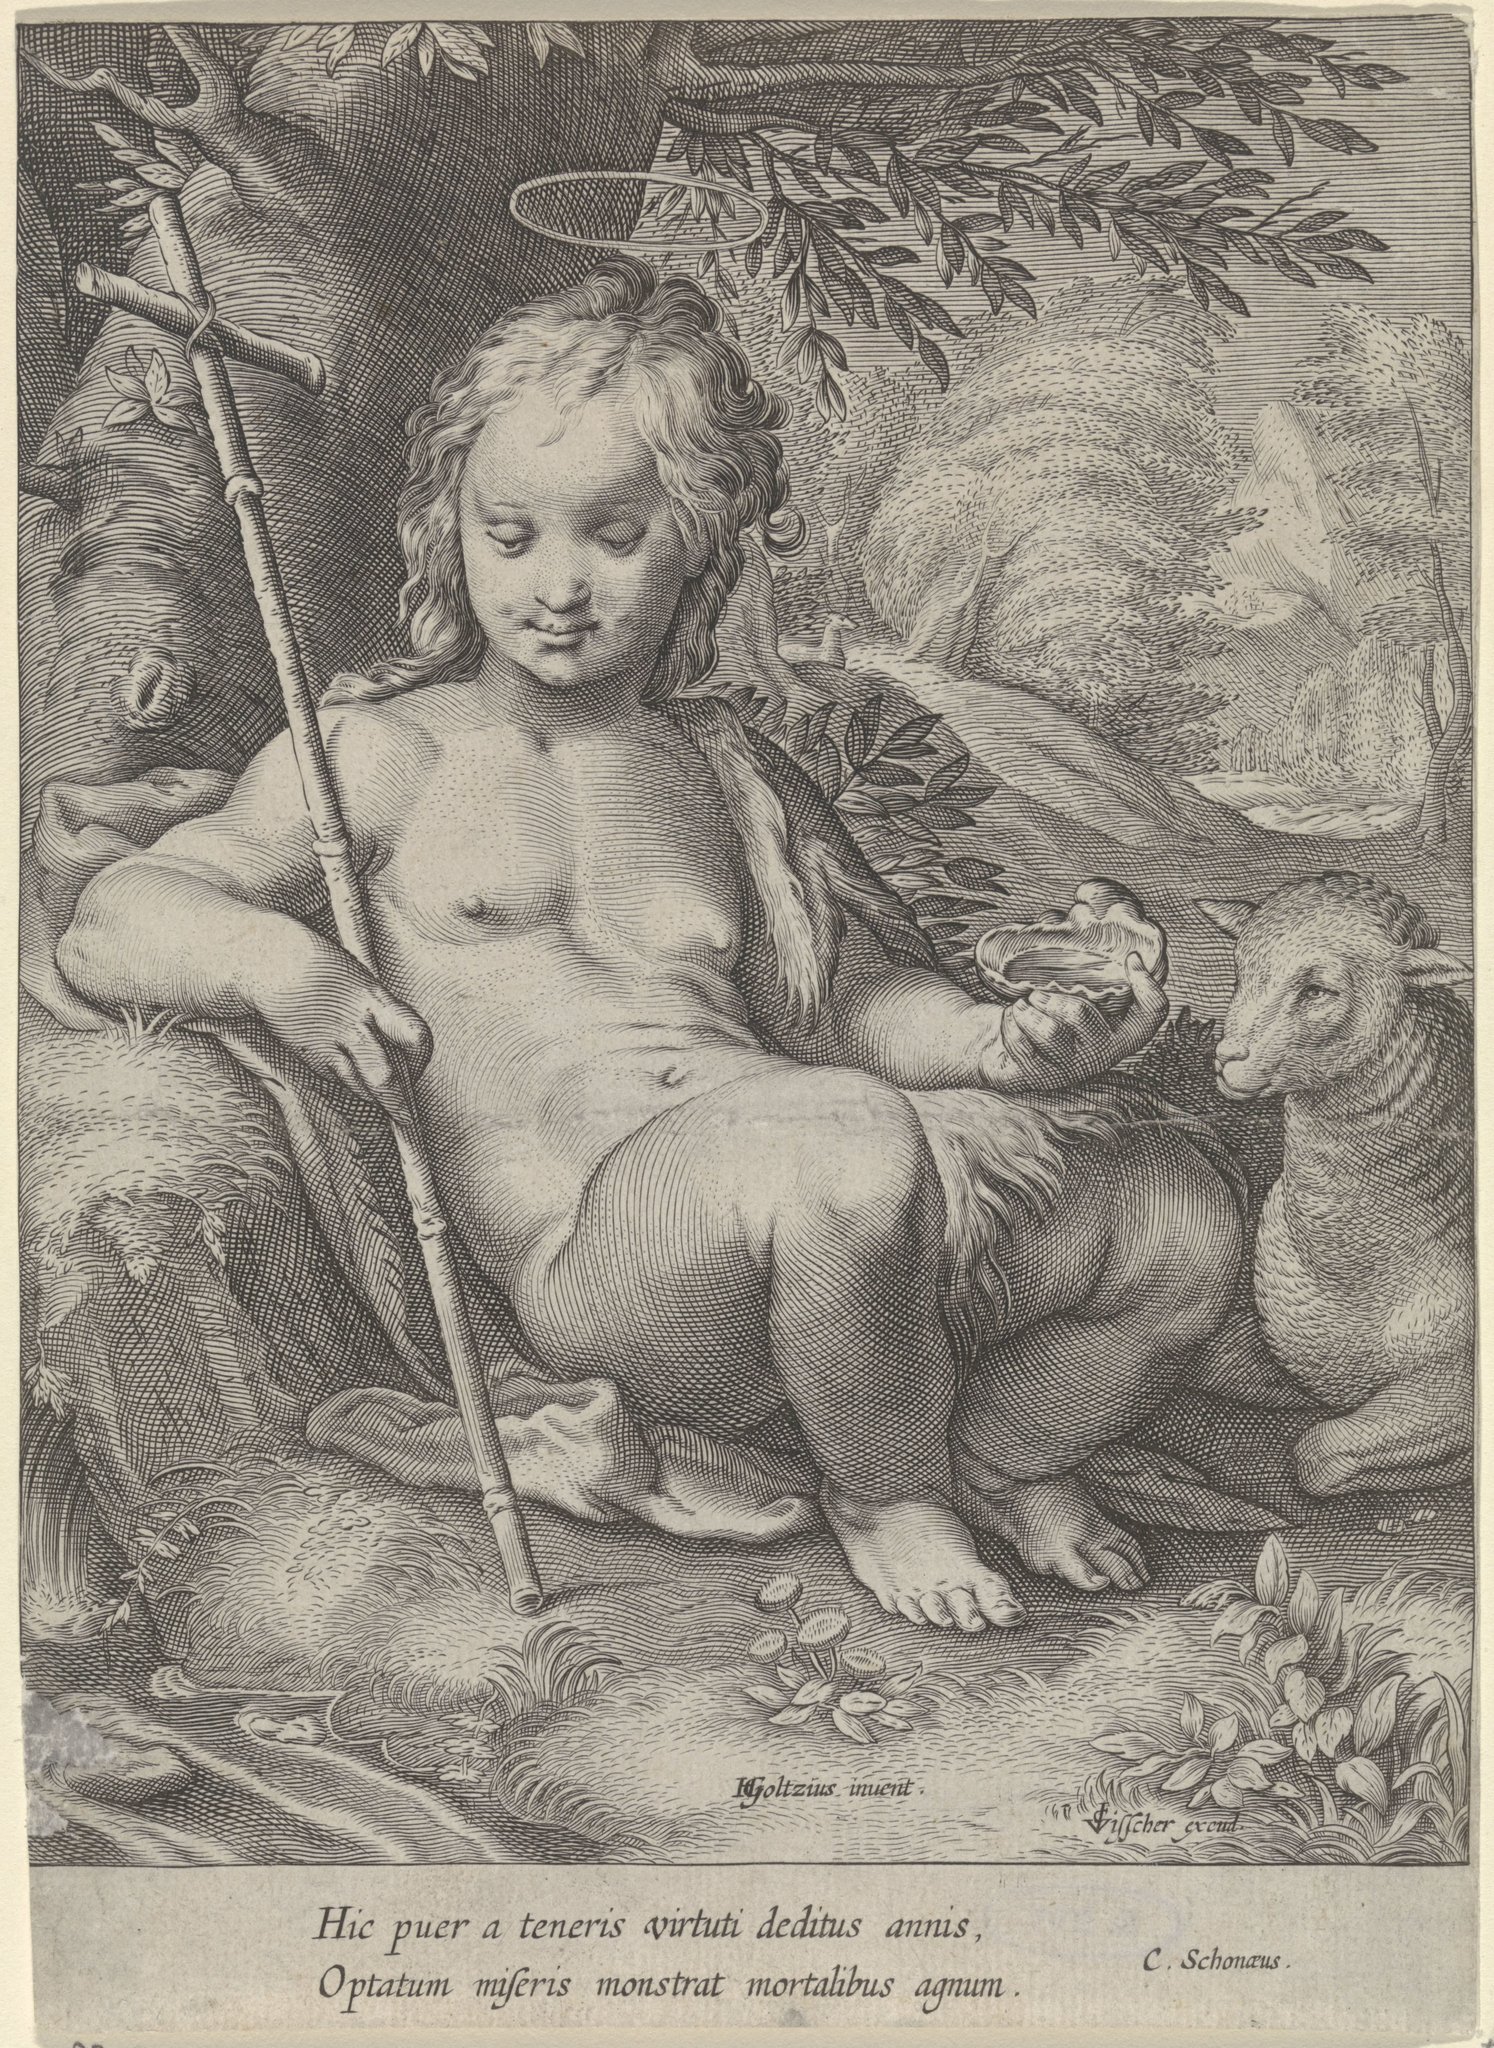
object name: print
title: Johannes de Doper als kind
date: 1601-1652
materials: paper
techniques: engraving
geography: amsterdam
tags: john the baptist in the wilderness, usually accompanied by a lamb (+ variant), story of the birth and youth of john the baptist (luke 1:5-25, 1:57-80)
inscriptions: collector's mark: Lugt 2228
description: Johannes de Doper als kind, rustend in een landschap naast een stroompje, met in zijn hand een kruis en naast hem een lam. In zijn linkerhand heeft hij een schelp.